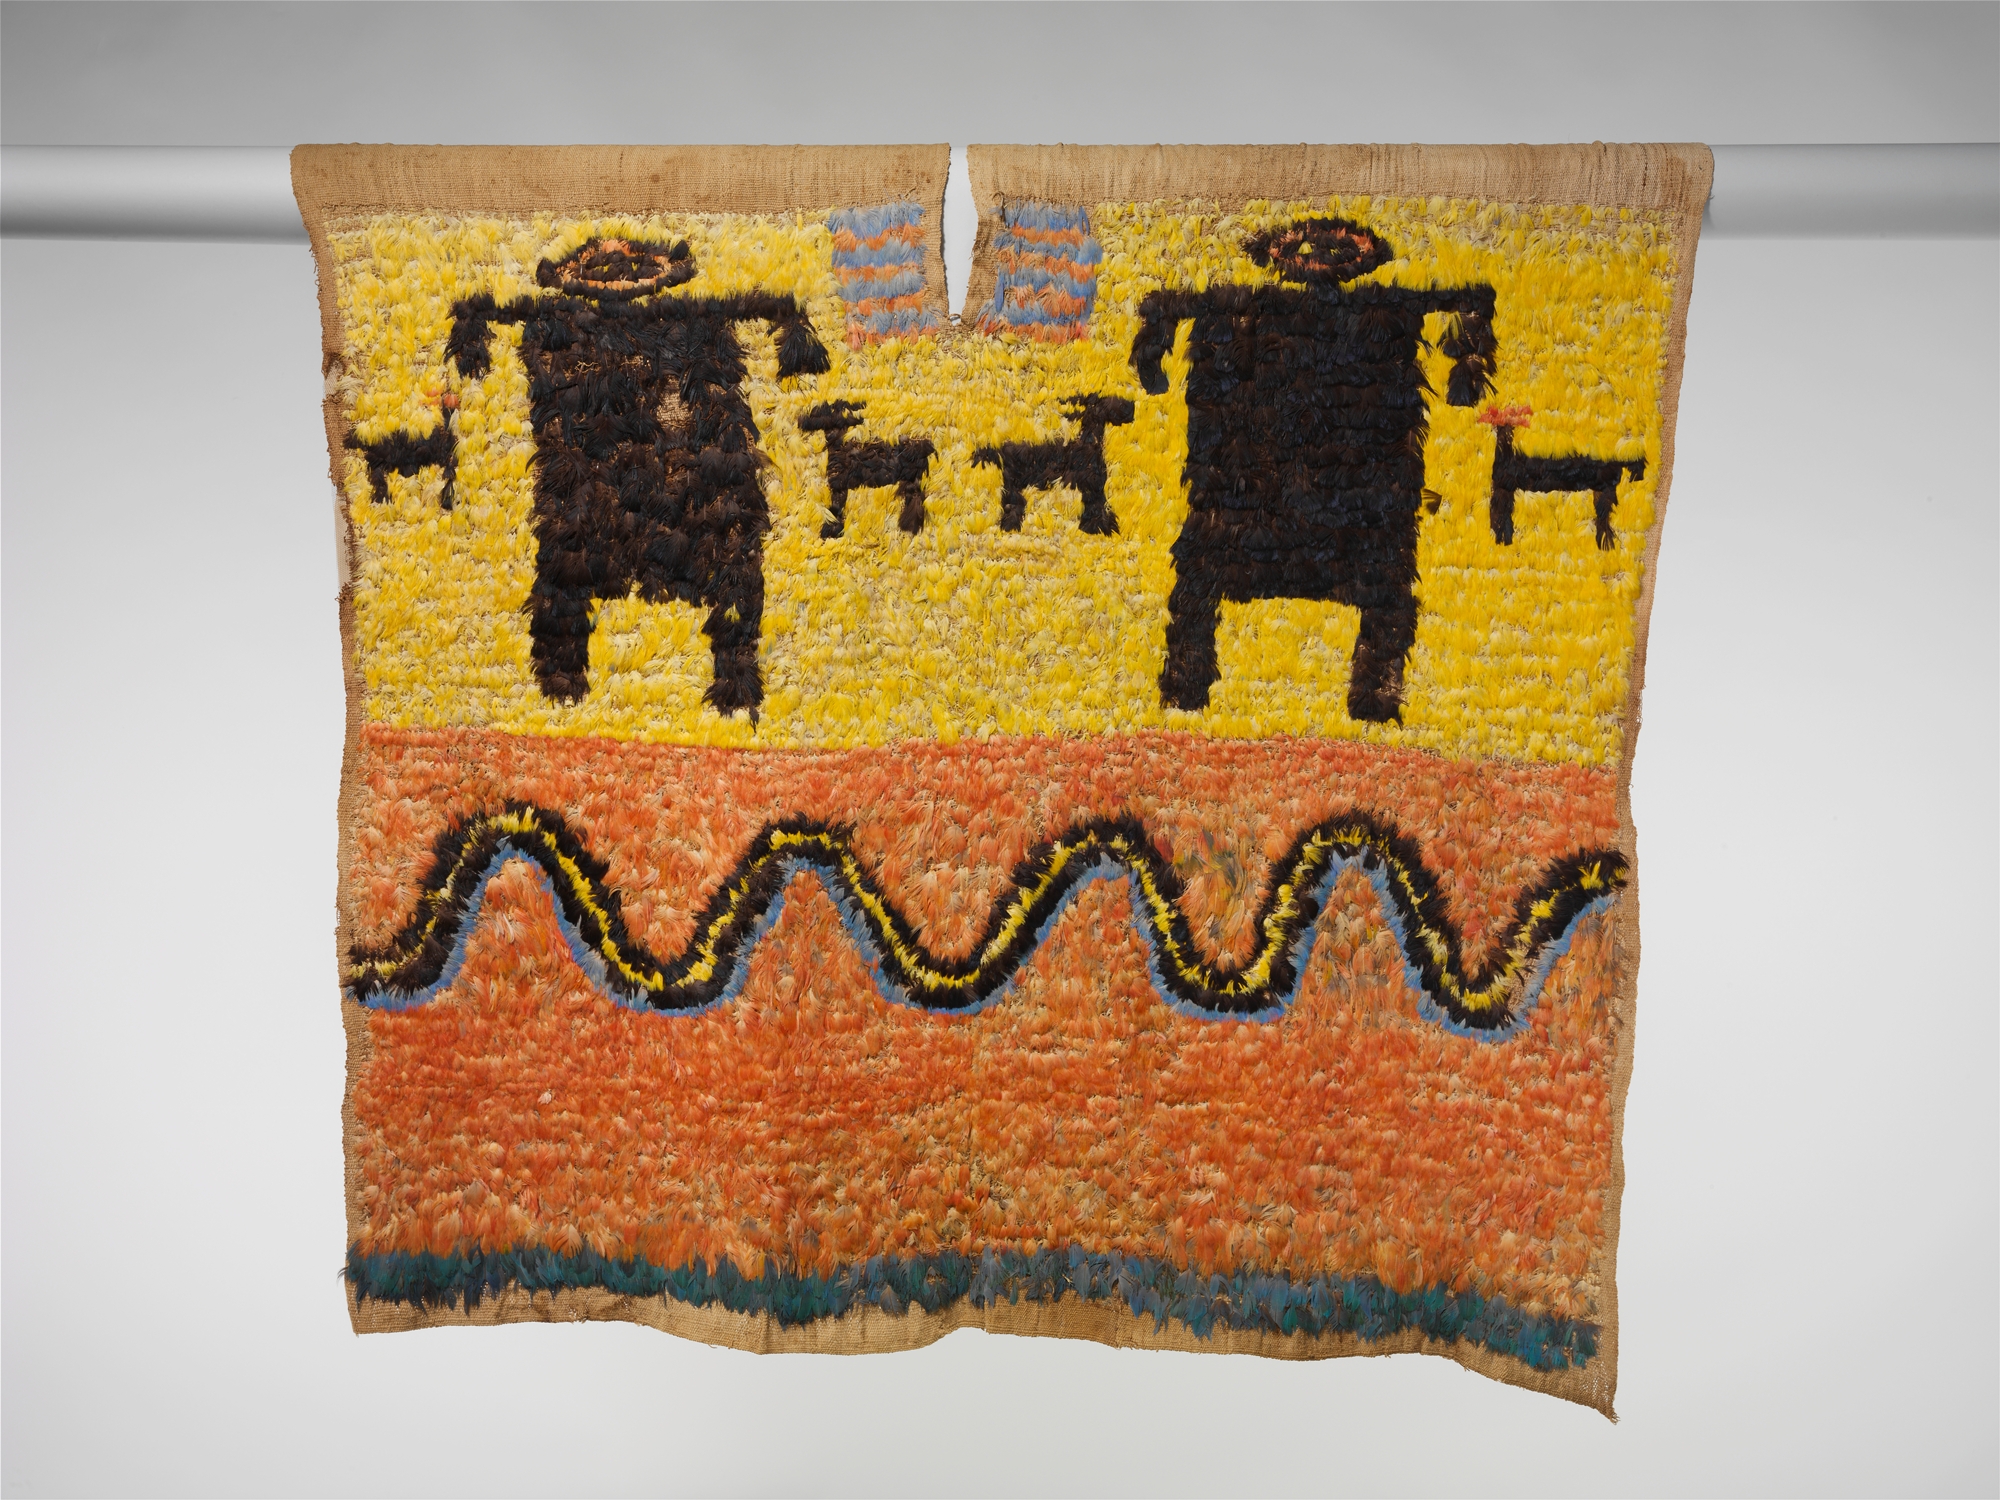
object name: tunic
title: Feathered Tabard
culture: inca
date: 1201-1400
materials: cotton, feather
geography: peru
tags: human figures,animals